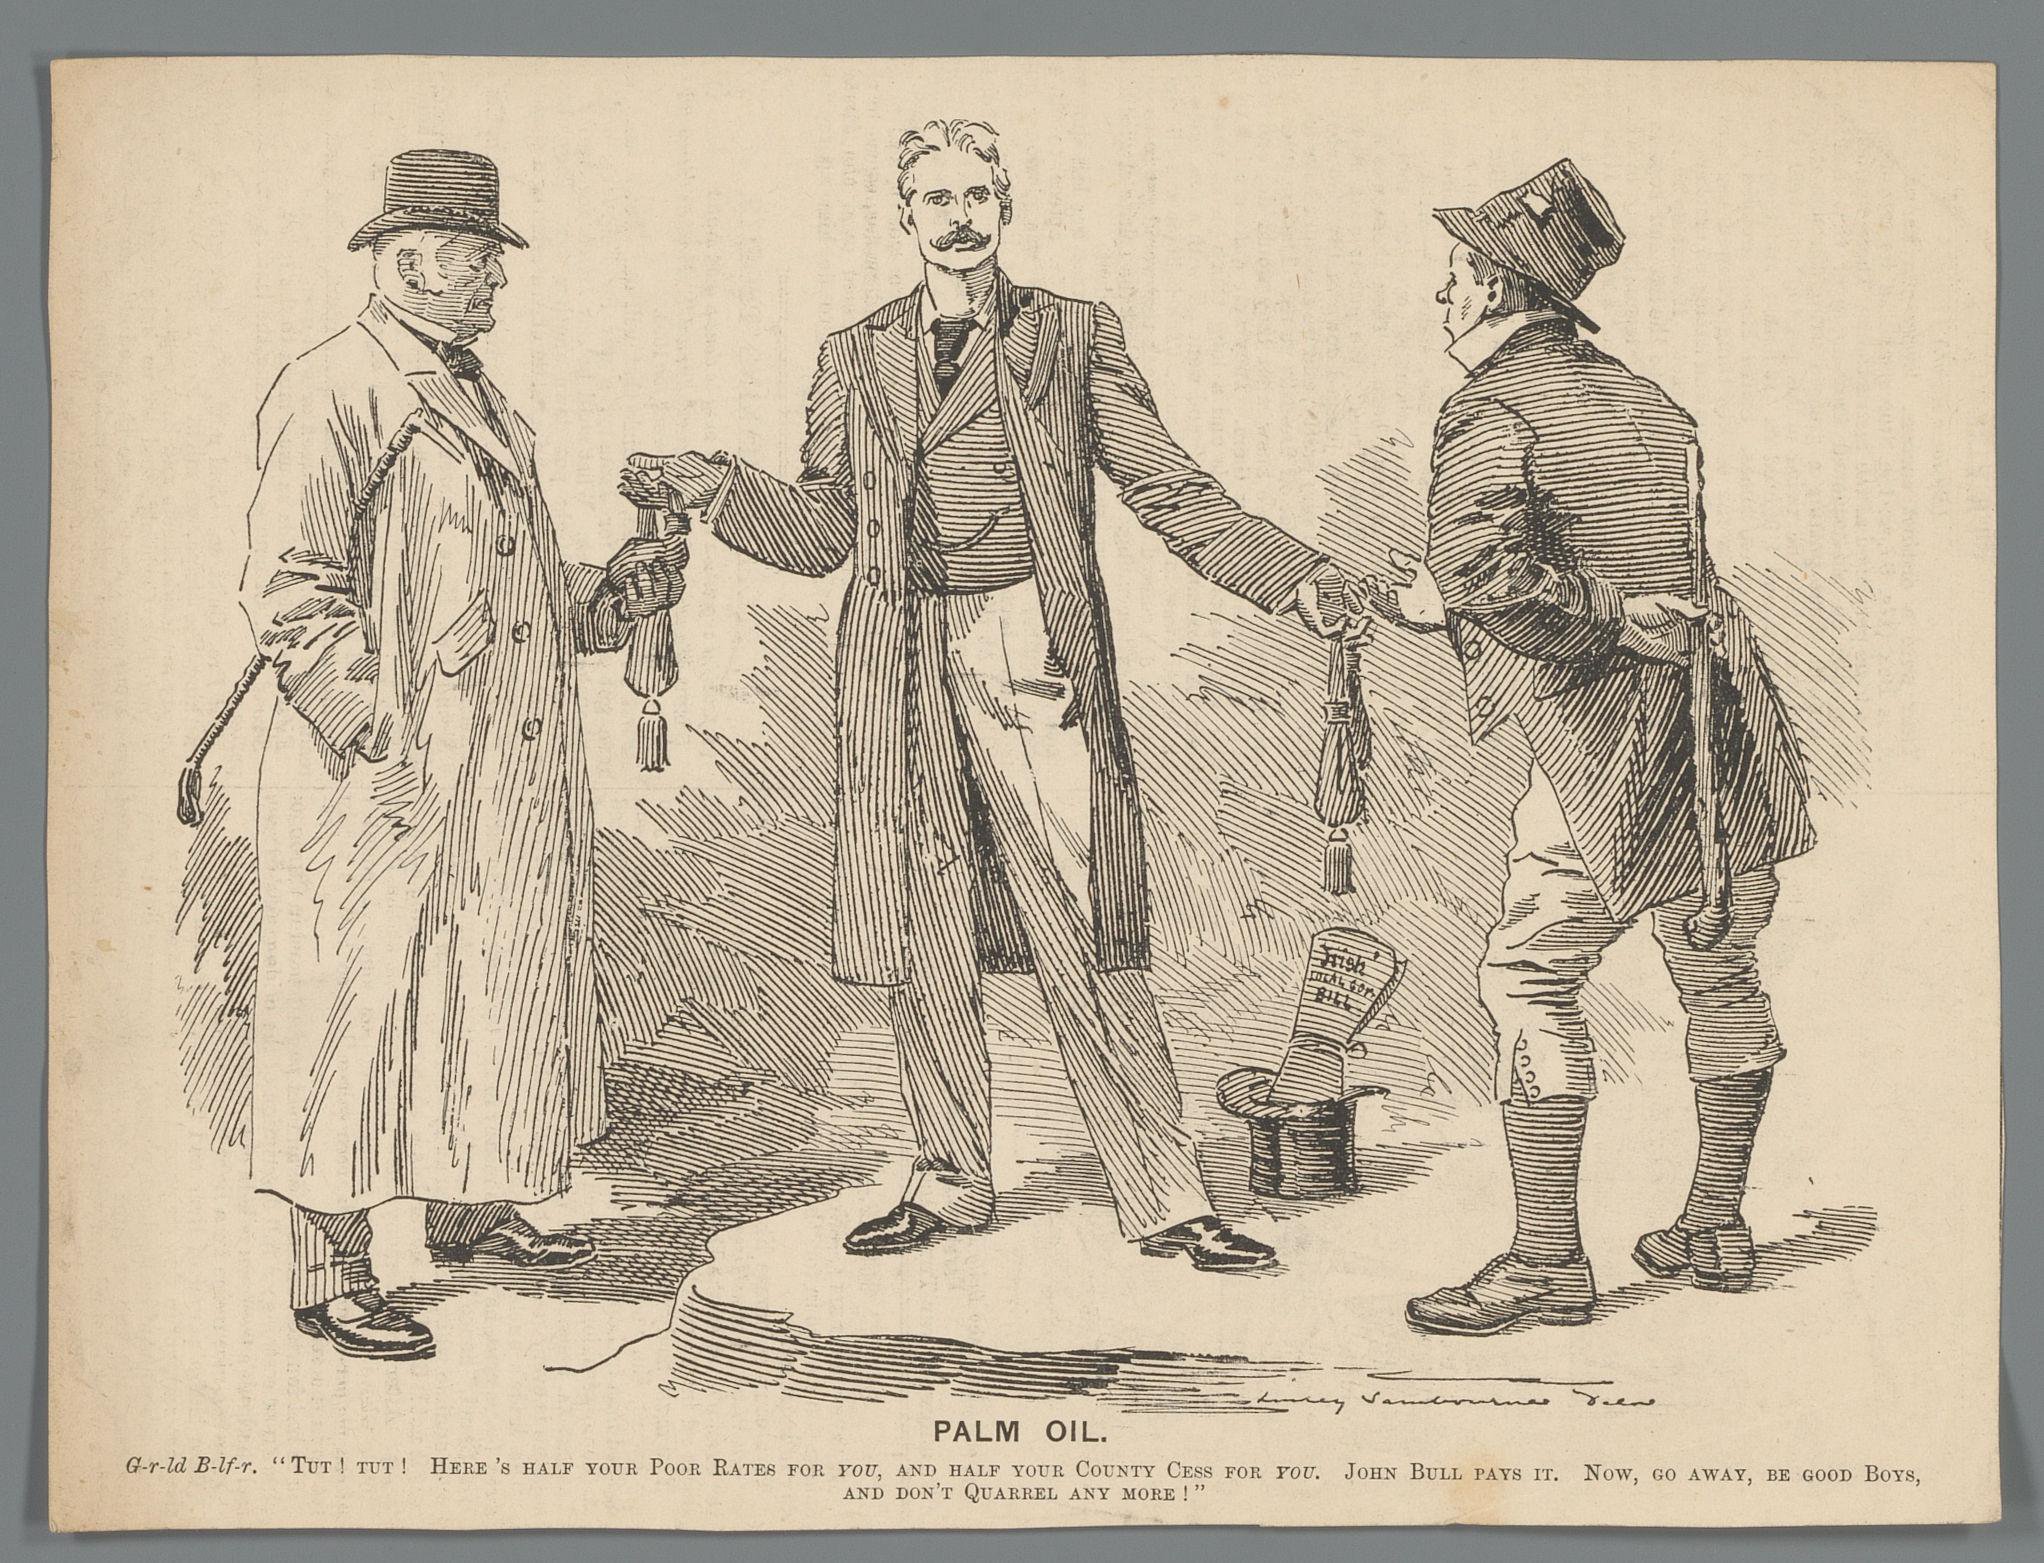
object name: cartoon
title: Palm Oil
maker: edward linley sambourne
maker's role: draughtsman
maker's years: 1844-1910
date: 1898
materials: paper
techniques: line block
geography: england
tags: political caricatures and satires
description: Gerald Balfour, Chief Secretary for Ireland, verdeelt geld. Politieke spotprent uit het Engelse satirische tijdschrift Punch, 1898.